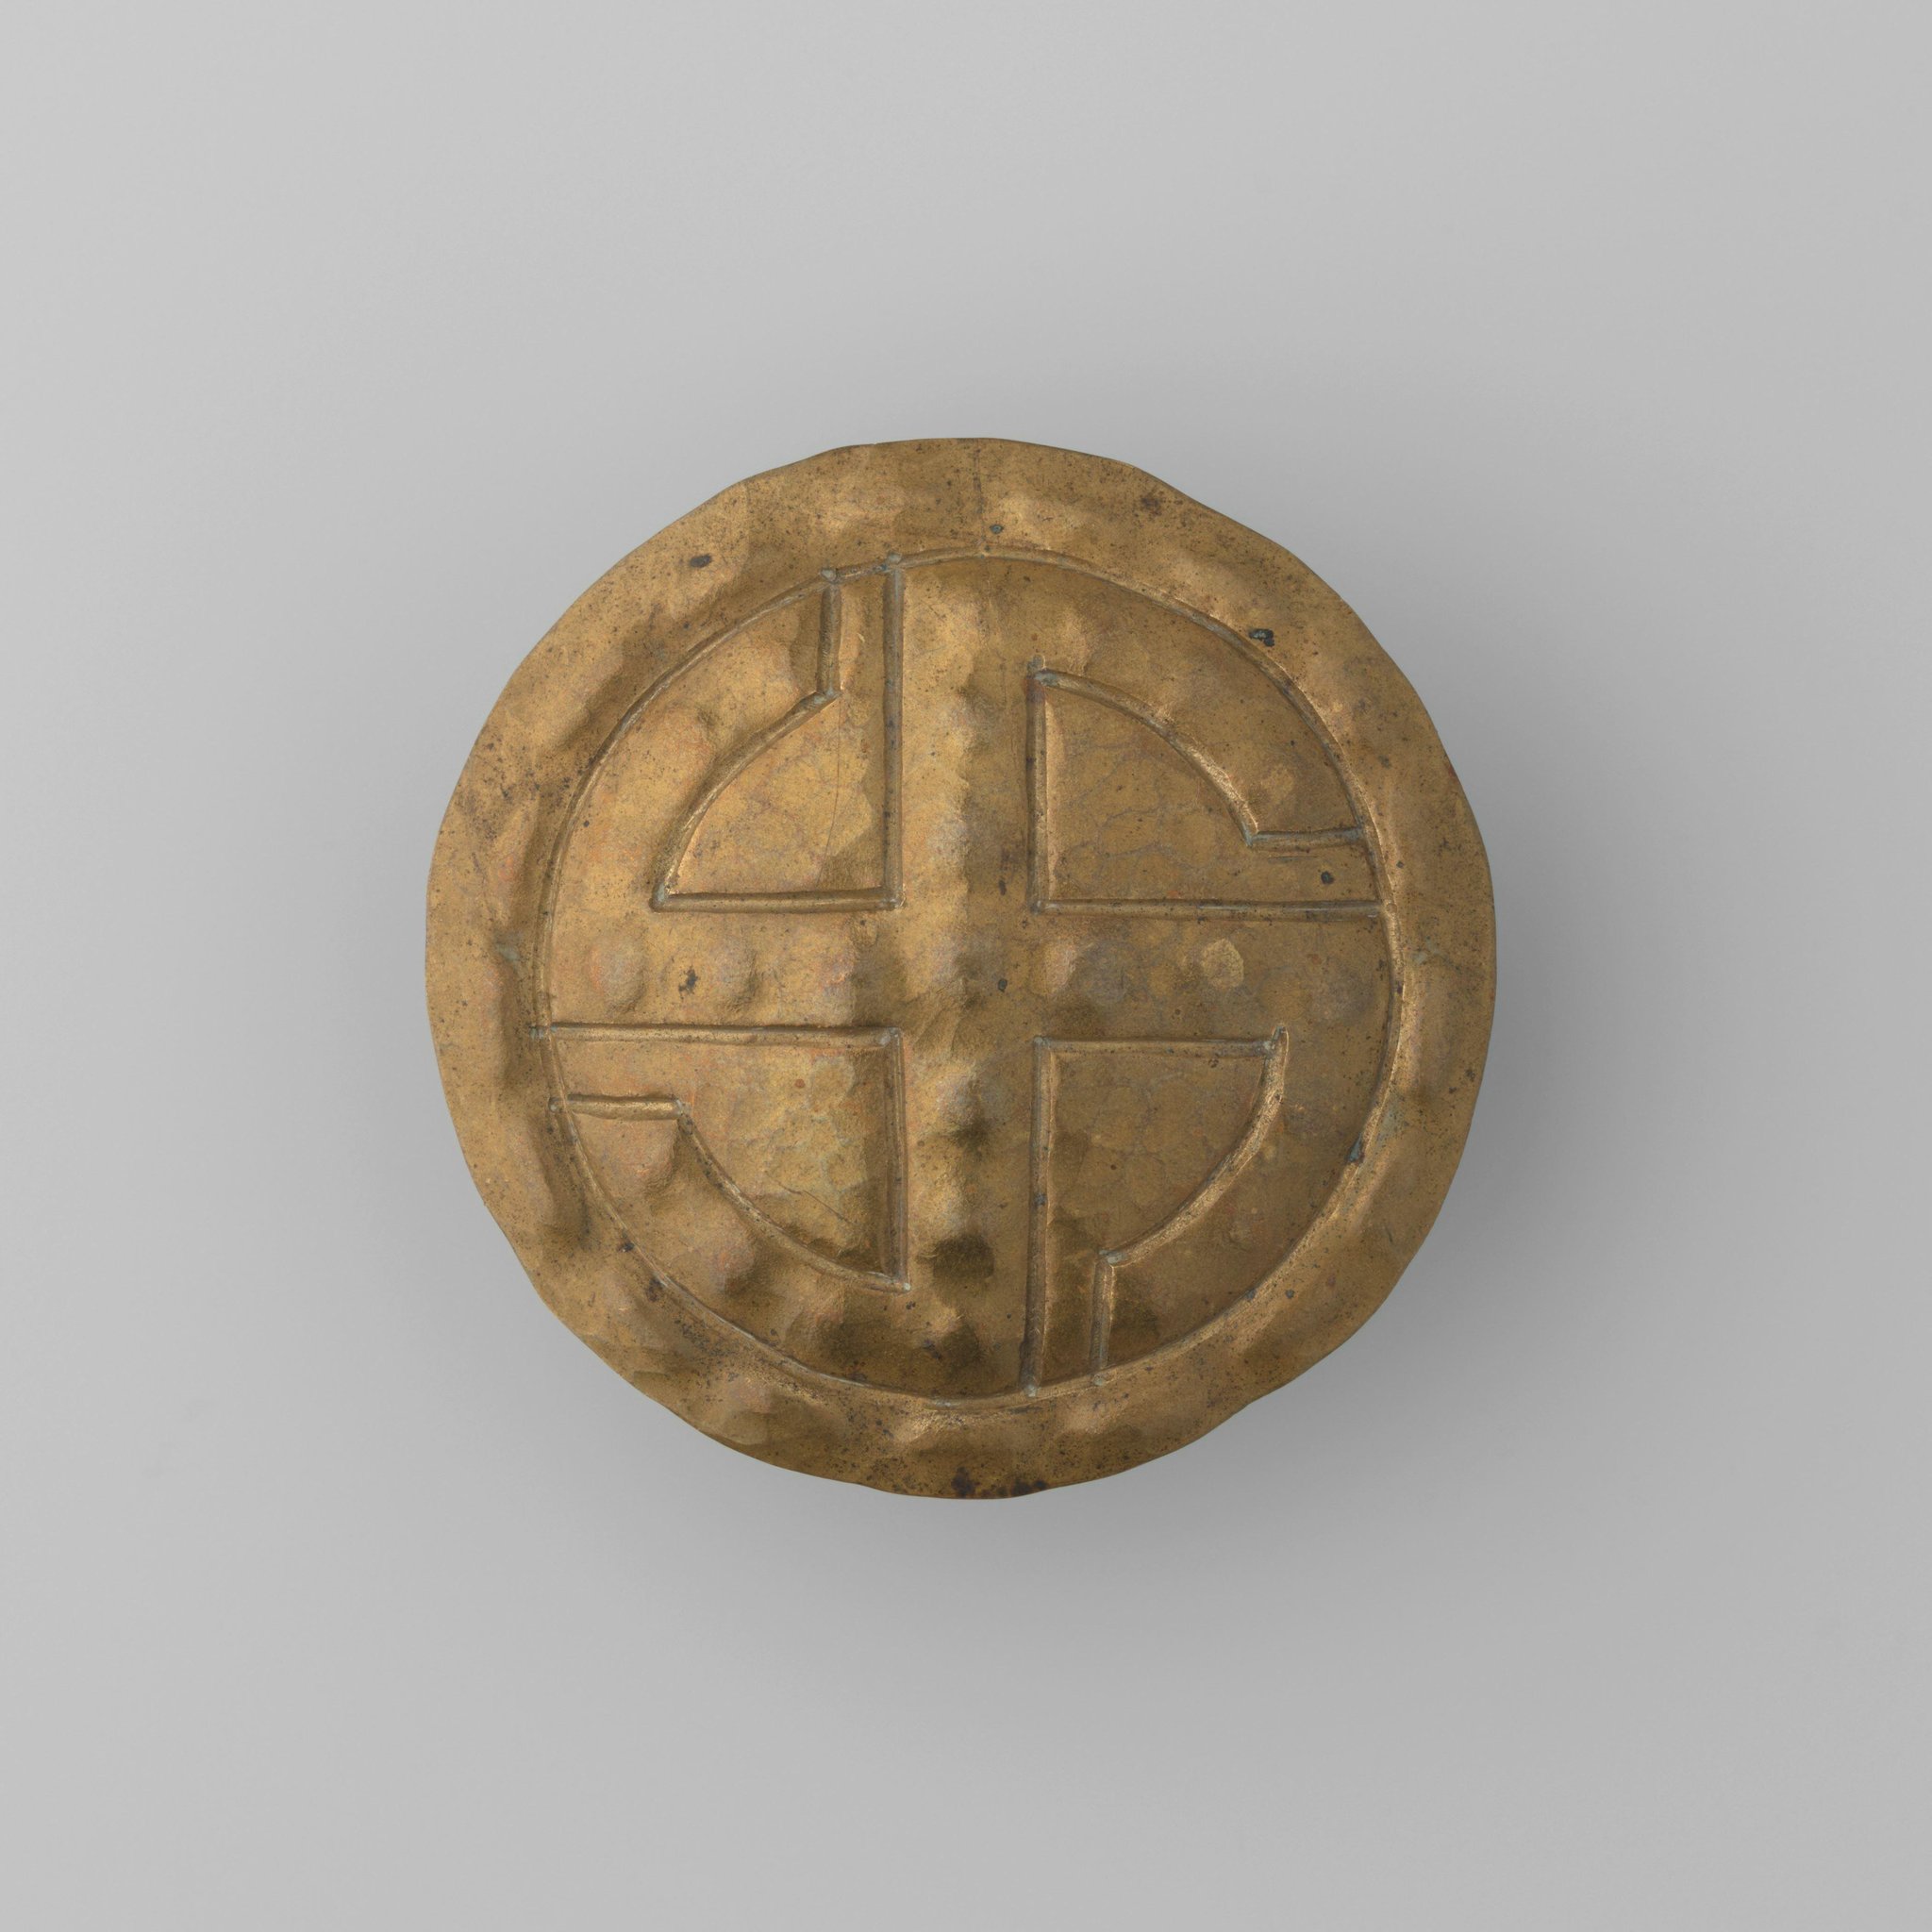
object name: brooch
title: Ronde broche van onedel metaal met kruisvorm in reliëf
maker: Anonymous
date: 1940-1945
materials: metal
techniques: hammering, soldering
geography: netherlands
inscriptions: : ‘H.W. OLUS’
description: Ronde convexe broche van onedel gehamerd goudkleurig metaal met kruisvorm in reliëf voorzien van een haaksluiting.